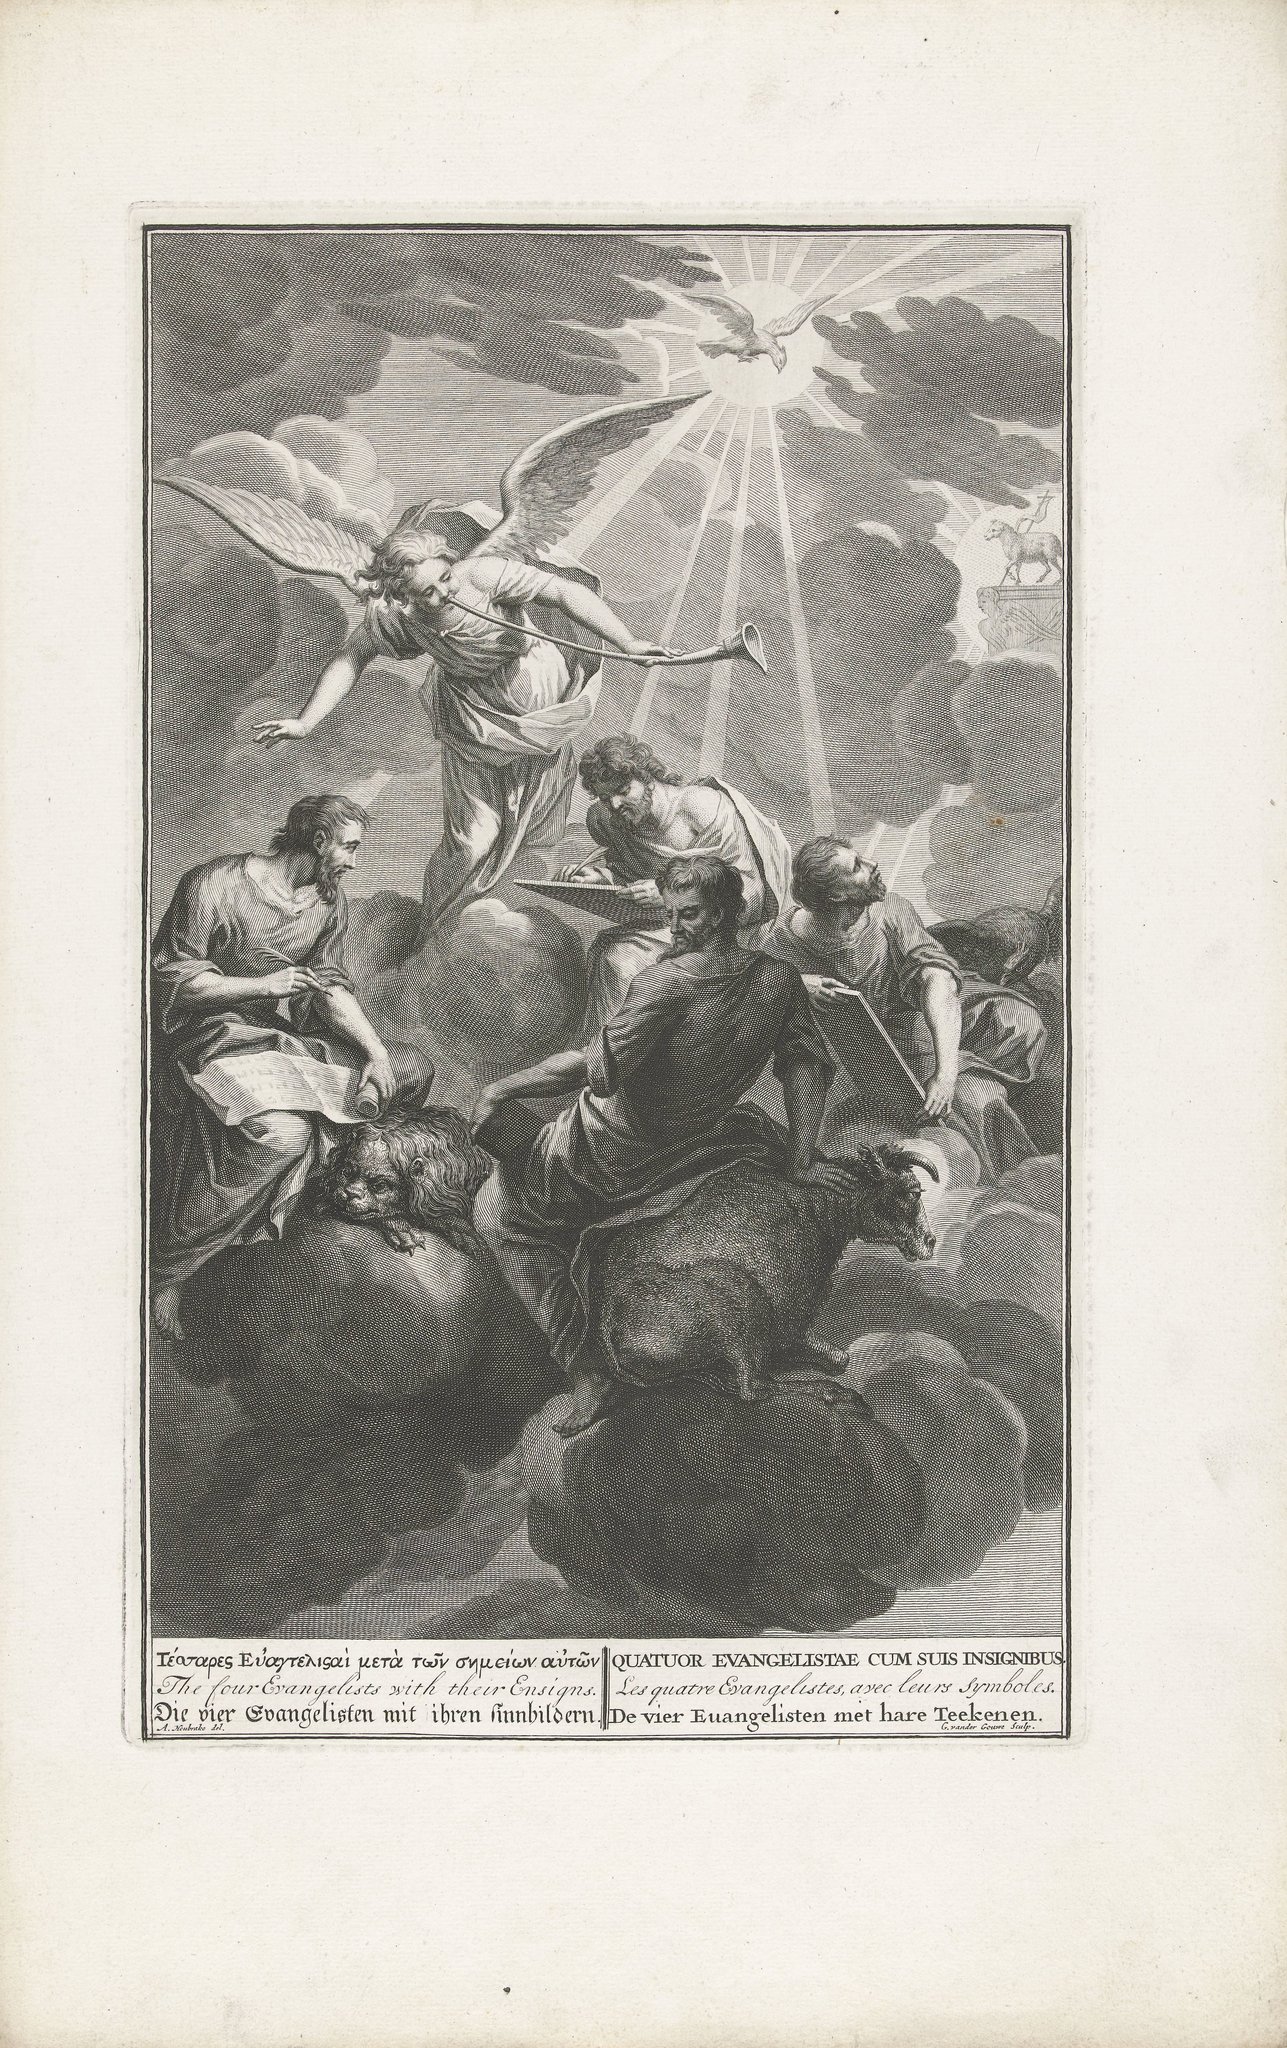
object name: book illustration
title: De vier evangelisten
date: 1728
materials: paper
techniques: engraving, etching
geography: the hague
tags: lamb bearing cross or banner, 'agnus dei' ~ symbol of christ, the evangelists writing (+ holy ghost (as a dove))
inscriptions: inscription: ‘utrechts Fundatie huijs’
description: De vier evangelisten in de wolken, samen met de apocalyptische dieren. Een engel met een bazuin blaast hen lof toe. Op de achtergrond de Heilige Geest als duif en het Lam Gods. De prent heeft een Grieks, Latijns, Frans, Engels, Duits en Nederlands onderschrift.